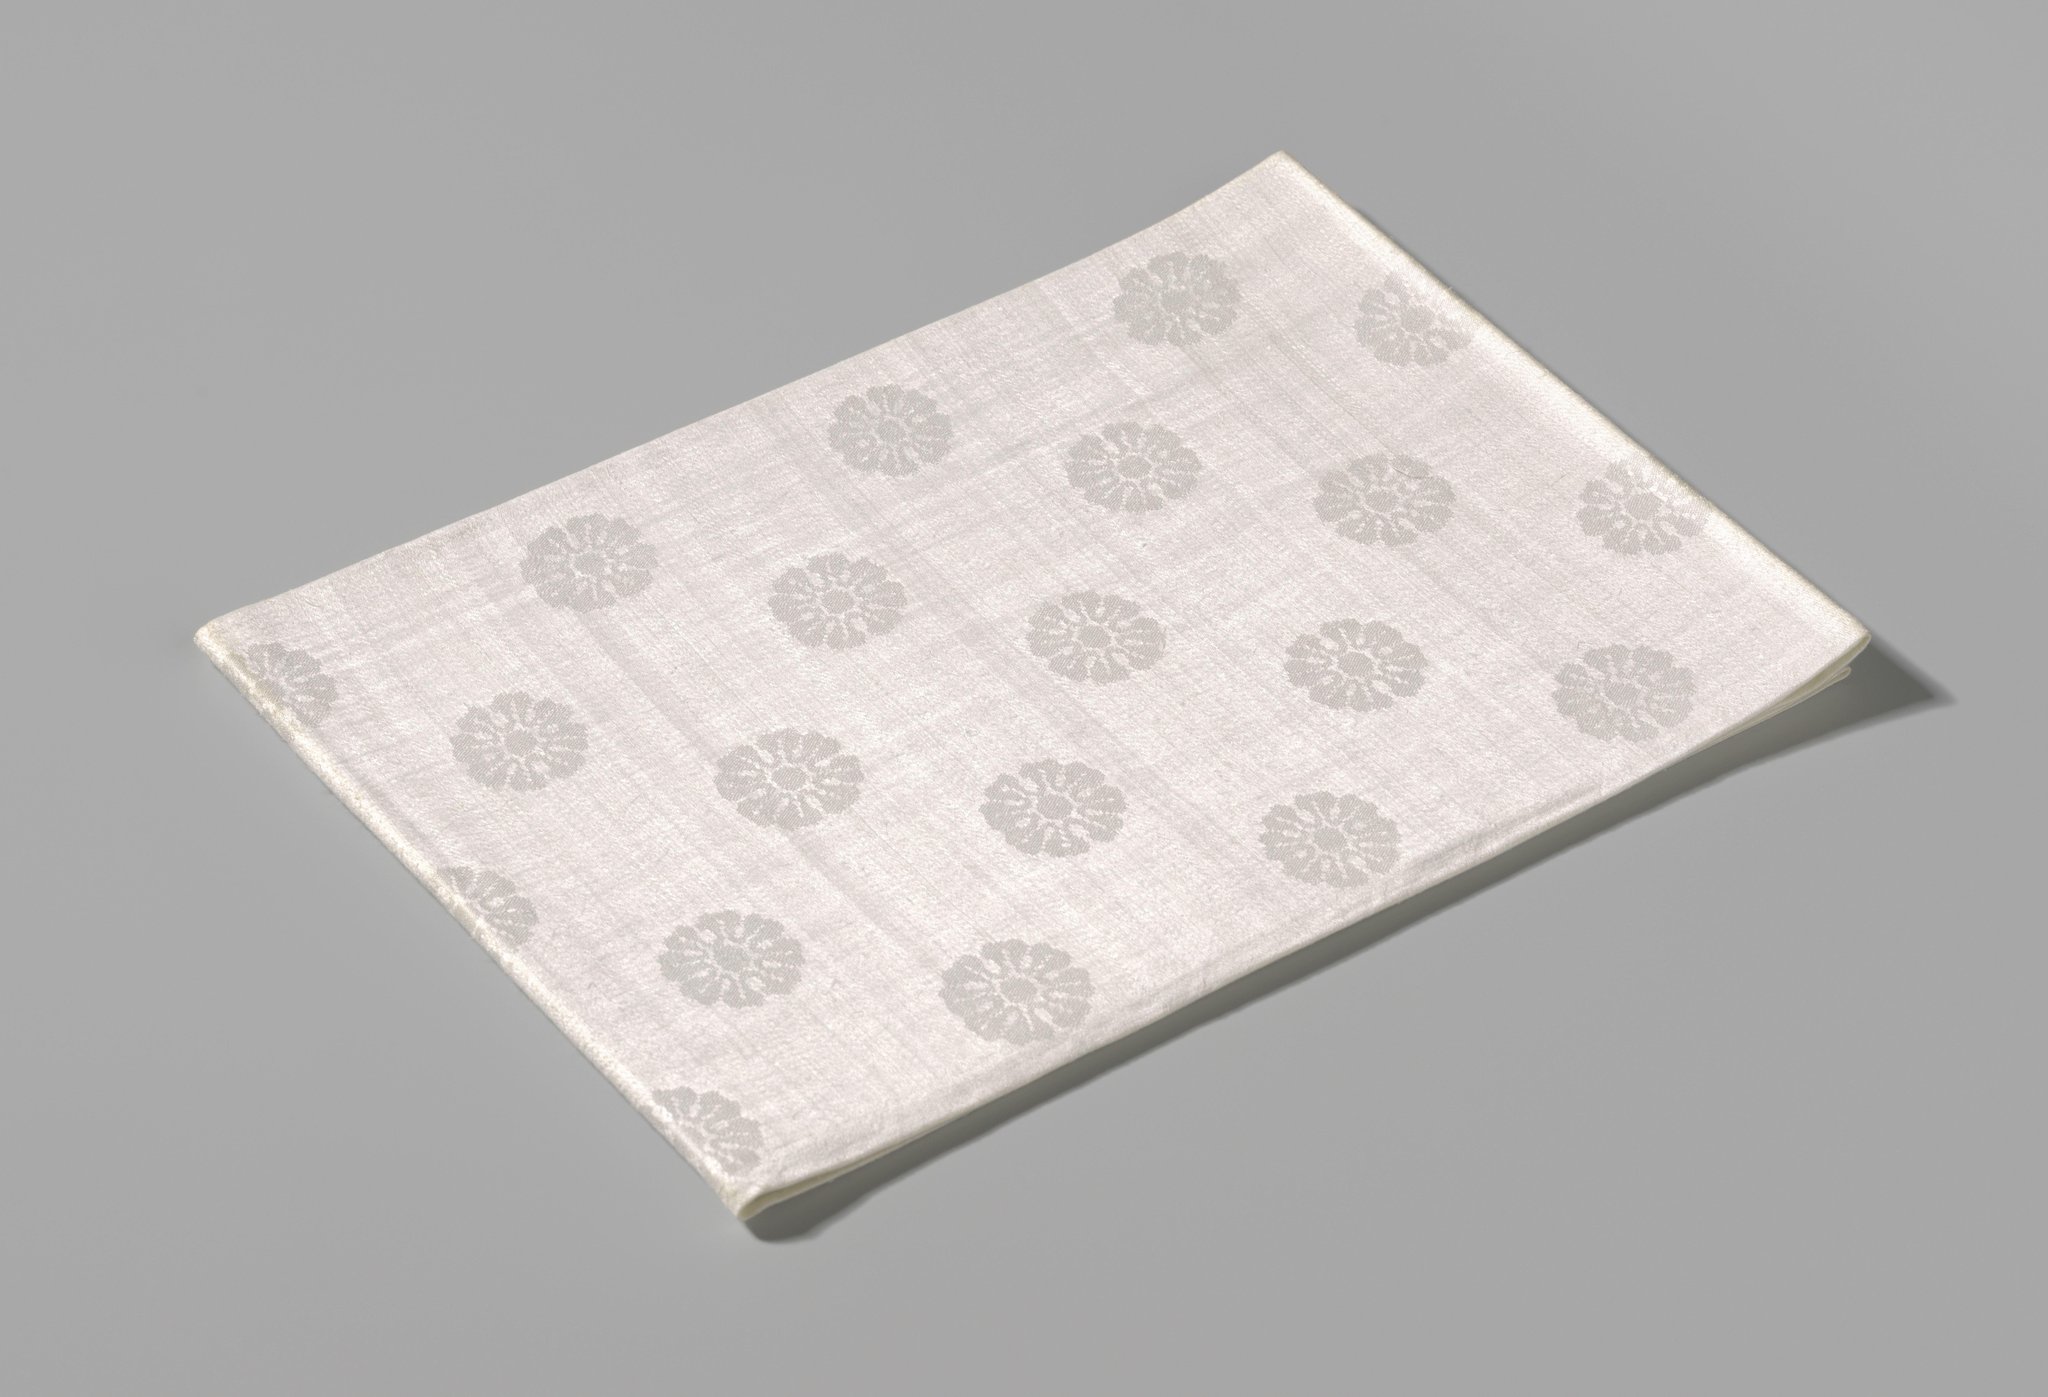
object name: napkin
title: Servet van linnendamast met een bloempatroon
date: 1849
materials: linen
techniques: damask, weave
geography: northern netherlands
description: Servet van linnendamast. Het veld heeft verspringende rijen rozetten en de randen bloemen en acanthusbladeren. De hoeken hebben een vaas met vruchten. Het servet is gemerkt: HW36 1849. Het servet hoort bij dertien servetten (BK-1980-377-A t/m BK-1980-377-N).